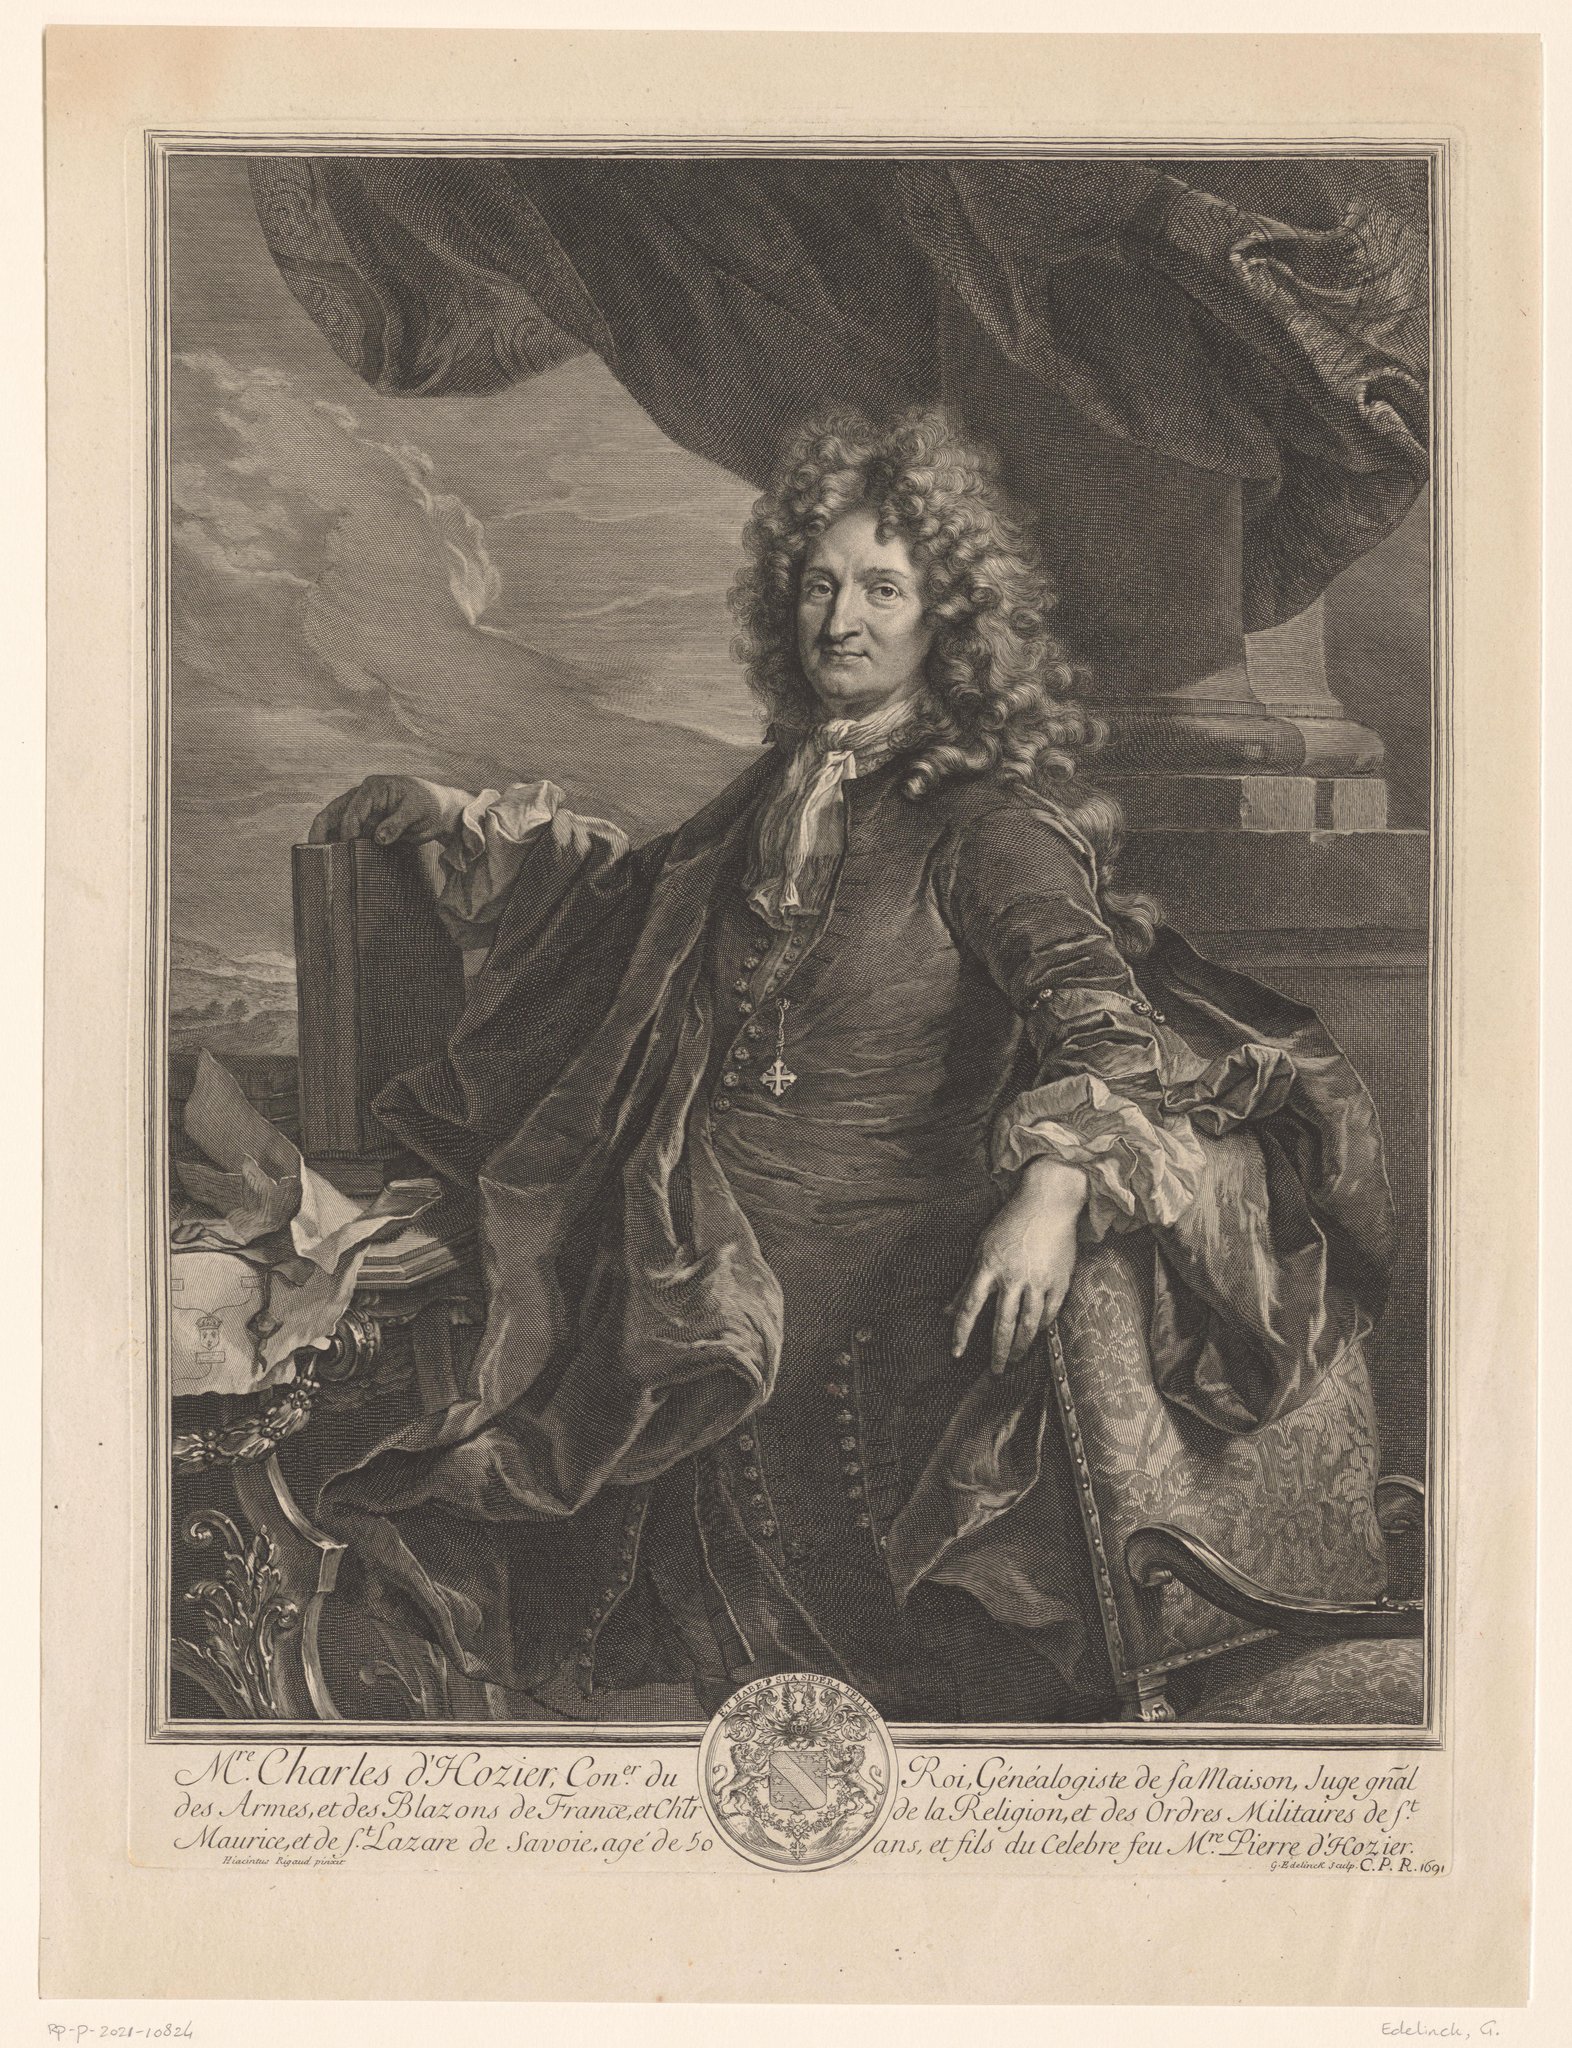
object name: print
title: Portret van Charles-René d'Hozier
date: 1691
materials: paper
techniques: engraving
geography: france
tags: historical persons, family lineage, pedigree, genealogical tree or table, book, armorial bearing, heraldry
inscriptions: date